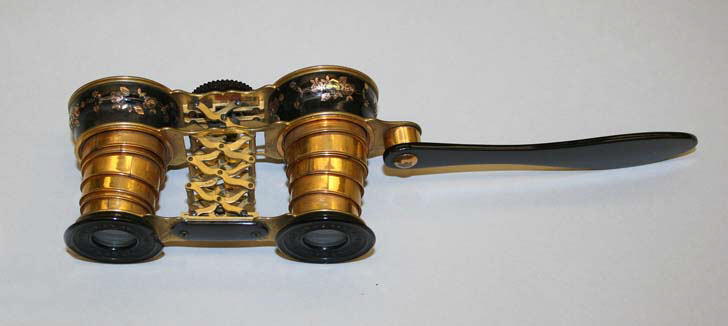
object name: opera glass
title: Opera glasses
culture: french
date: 1840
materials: metal, shell